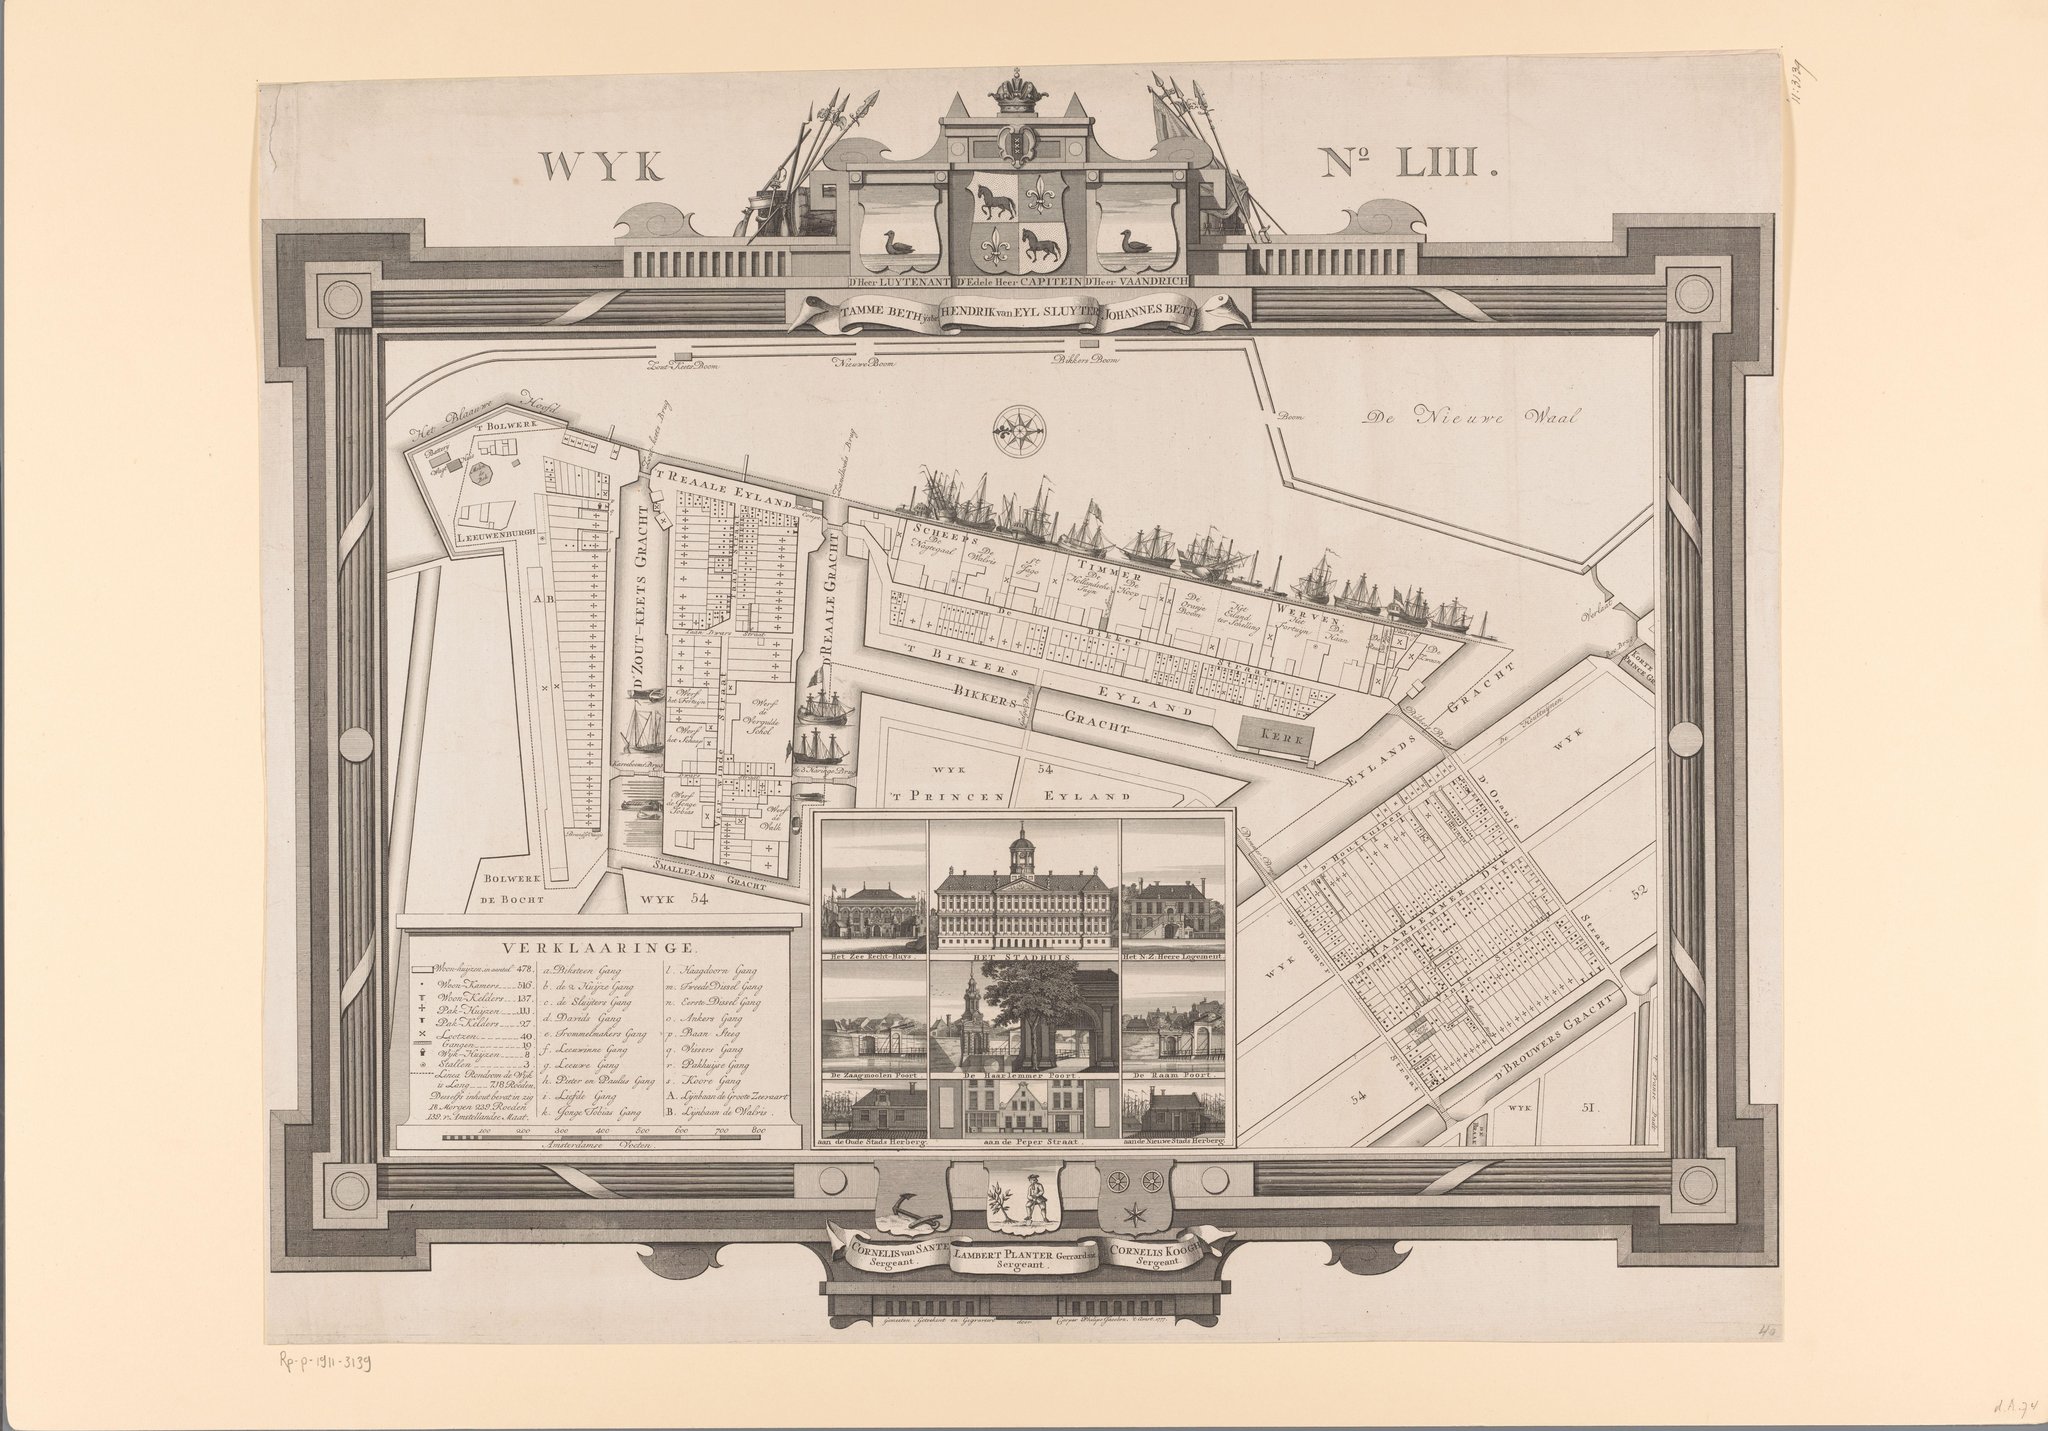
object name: area plan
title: Wyk No. LIII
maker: caspar jacobsz. philips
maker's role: draughtsman, print maker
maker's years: 1732-1789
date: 1777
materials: paper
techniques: engraving, etching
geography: amsterdam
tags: townhall, maps of cities, armorial bearing, heraldry, amsterdam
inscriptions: collector's mark: Lugt 2228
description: Linksonder een cartouche met informatie over de wijk. Midden onder negen gezichten op voorname gebouwen van de stad.